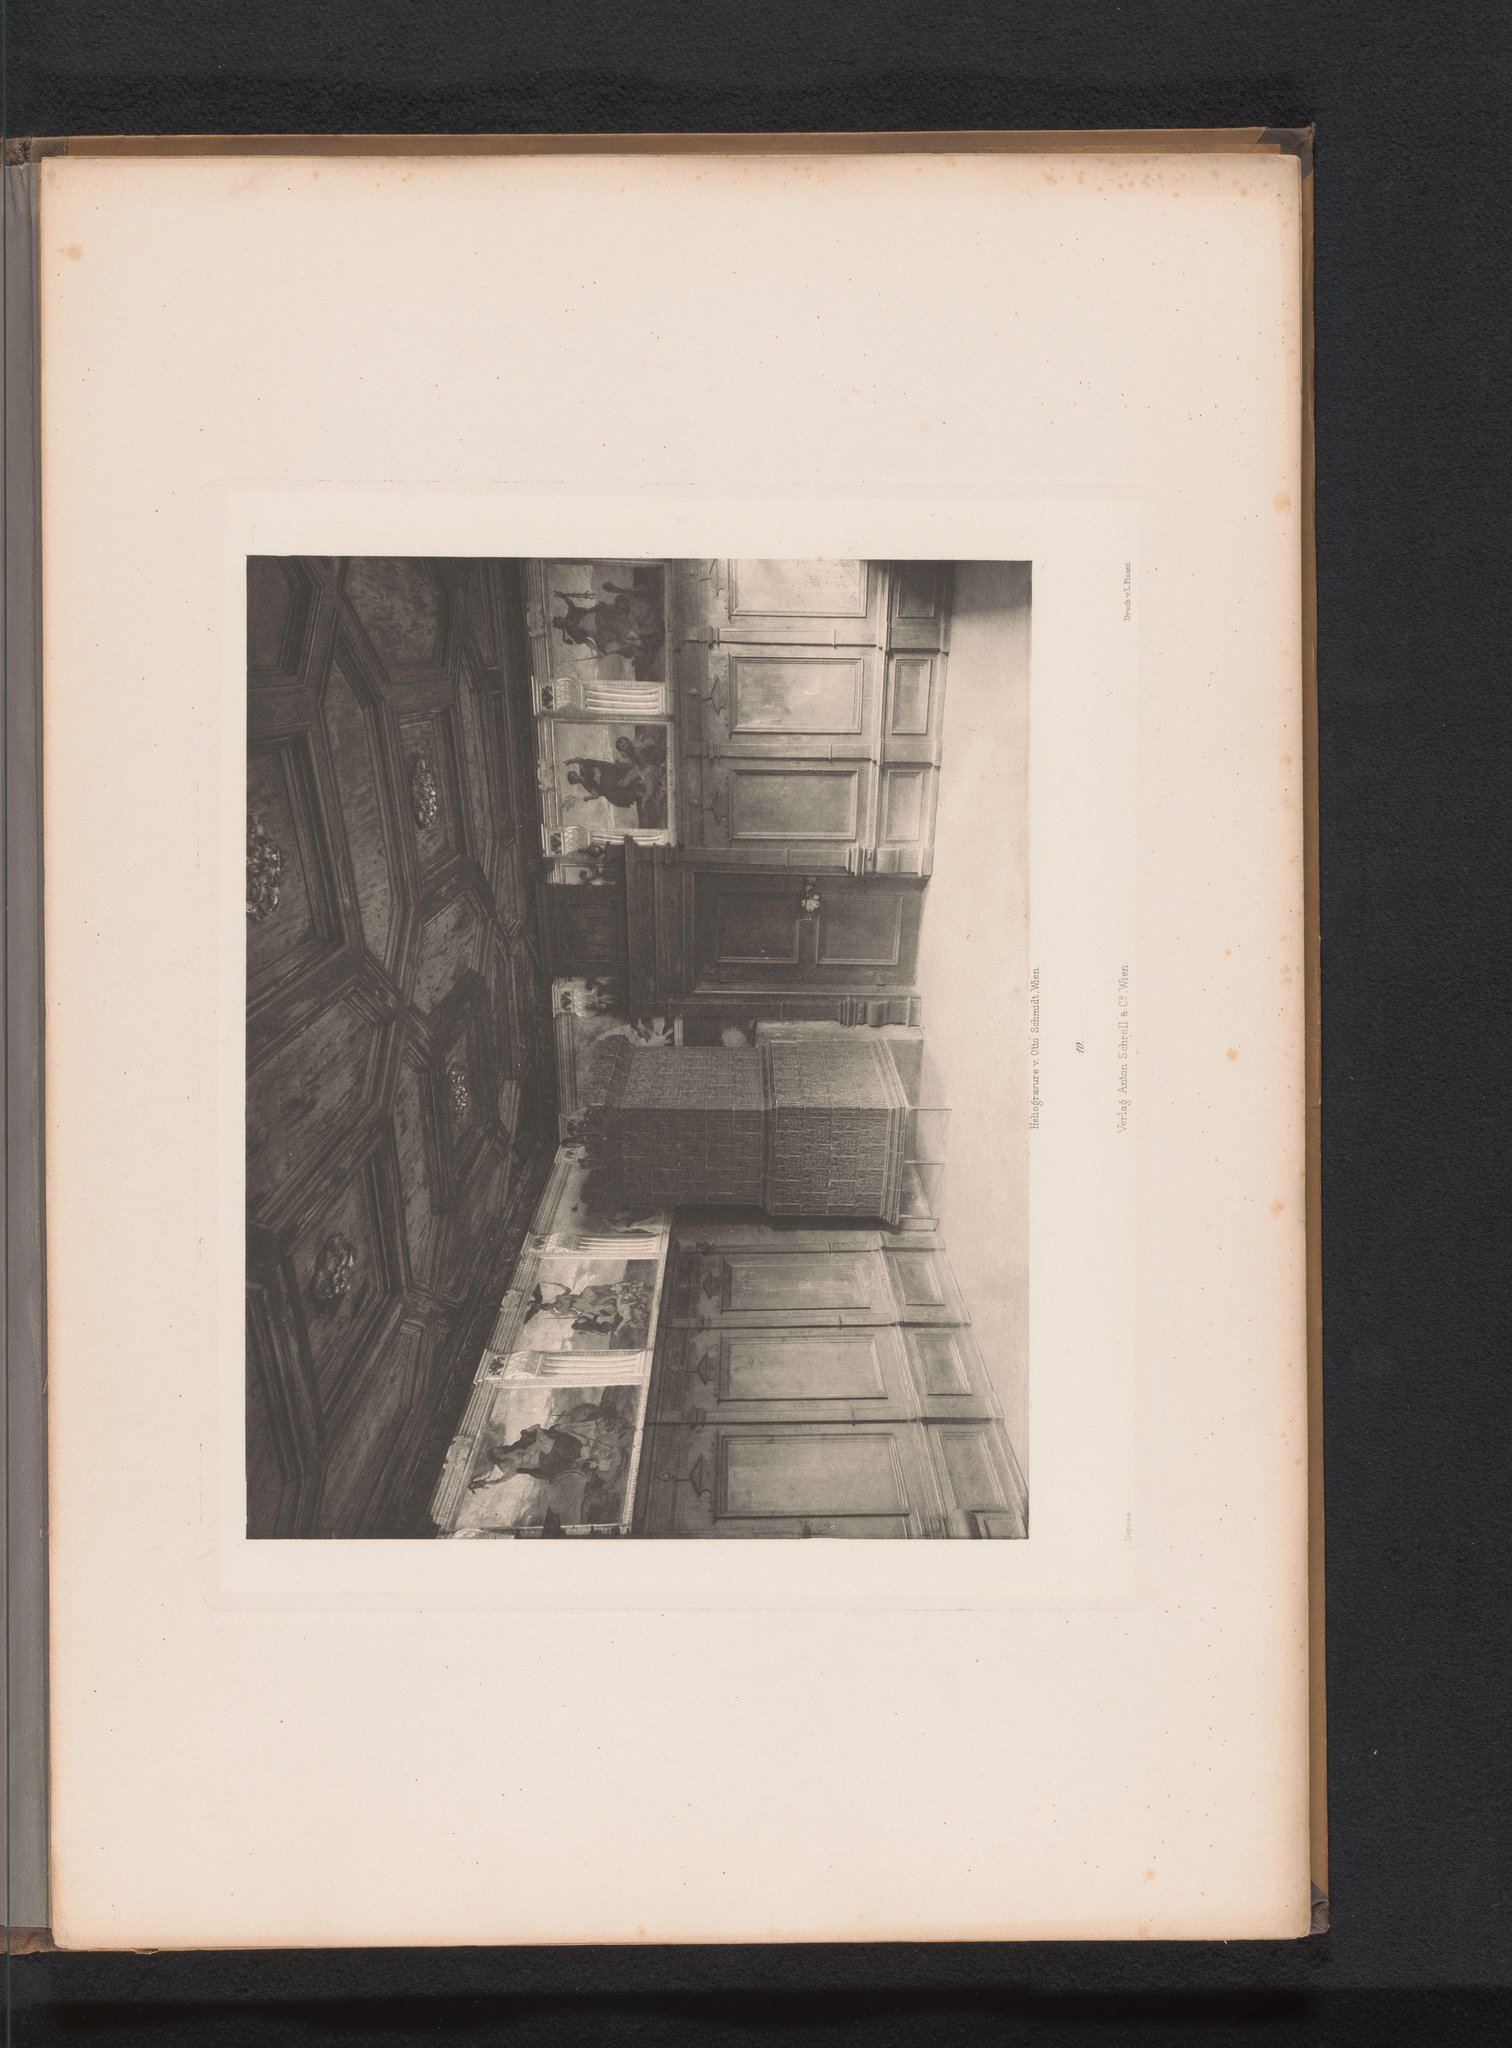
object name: photomechanical print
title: Gezicht op een kamer in Slot Velthurns bij Bressanone, Italië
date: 1886-1891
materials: paper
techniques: photoaquatint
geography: vienna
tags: castle - aa - civic architecture: inside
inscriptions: number: ‘10.’, inscription: ‘Déposé.’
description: Deze prent maakt deel uit van een omslag met dertig prenten en drie tekstbladen.